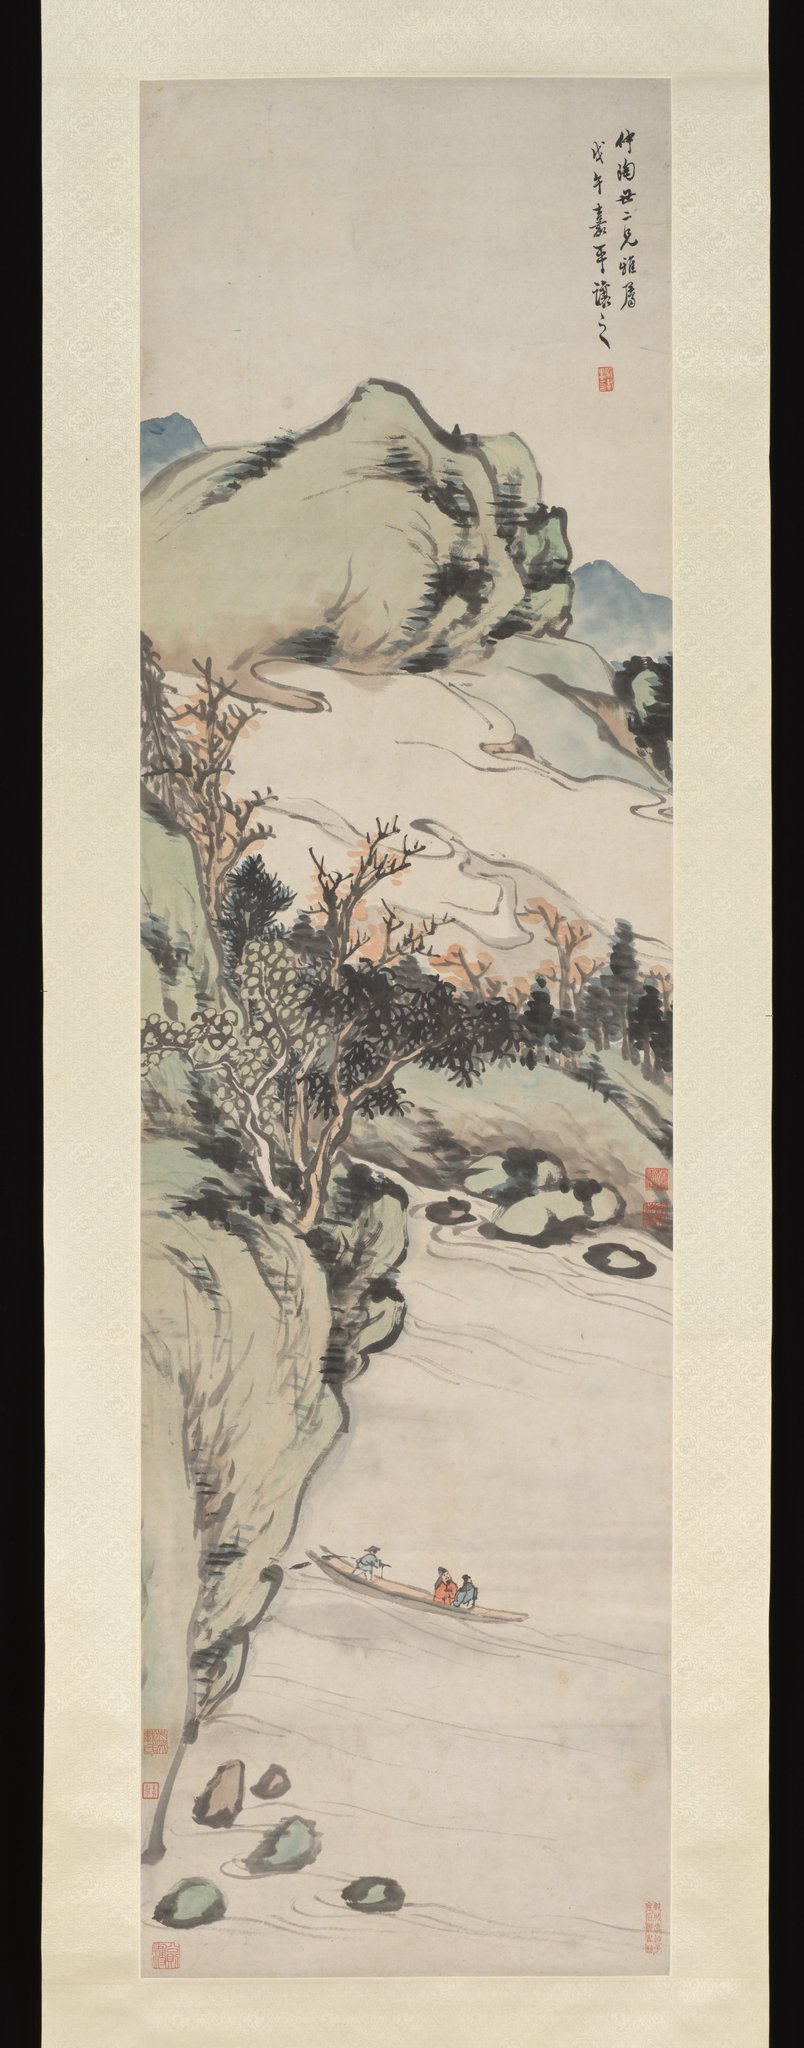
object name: hanging scroll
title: Landscape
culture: chinese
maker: wu xizai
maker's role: artist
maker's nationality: chinese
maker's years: 1799-1870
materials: ink, paper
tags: mountains,landscapes,boats